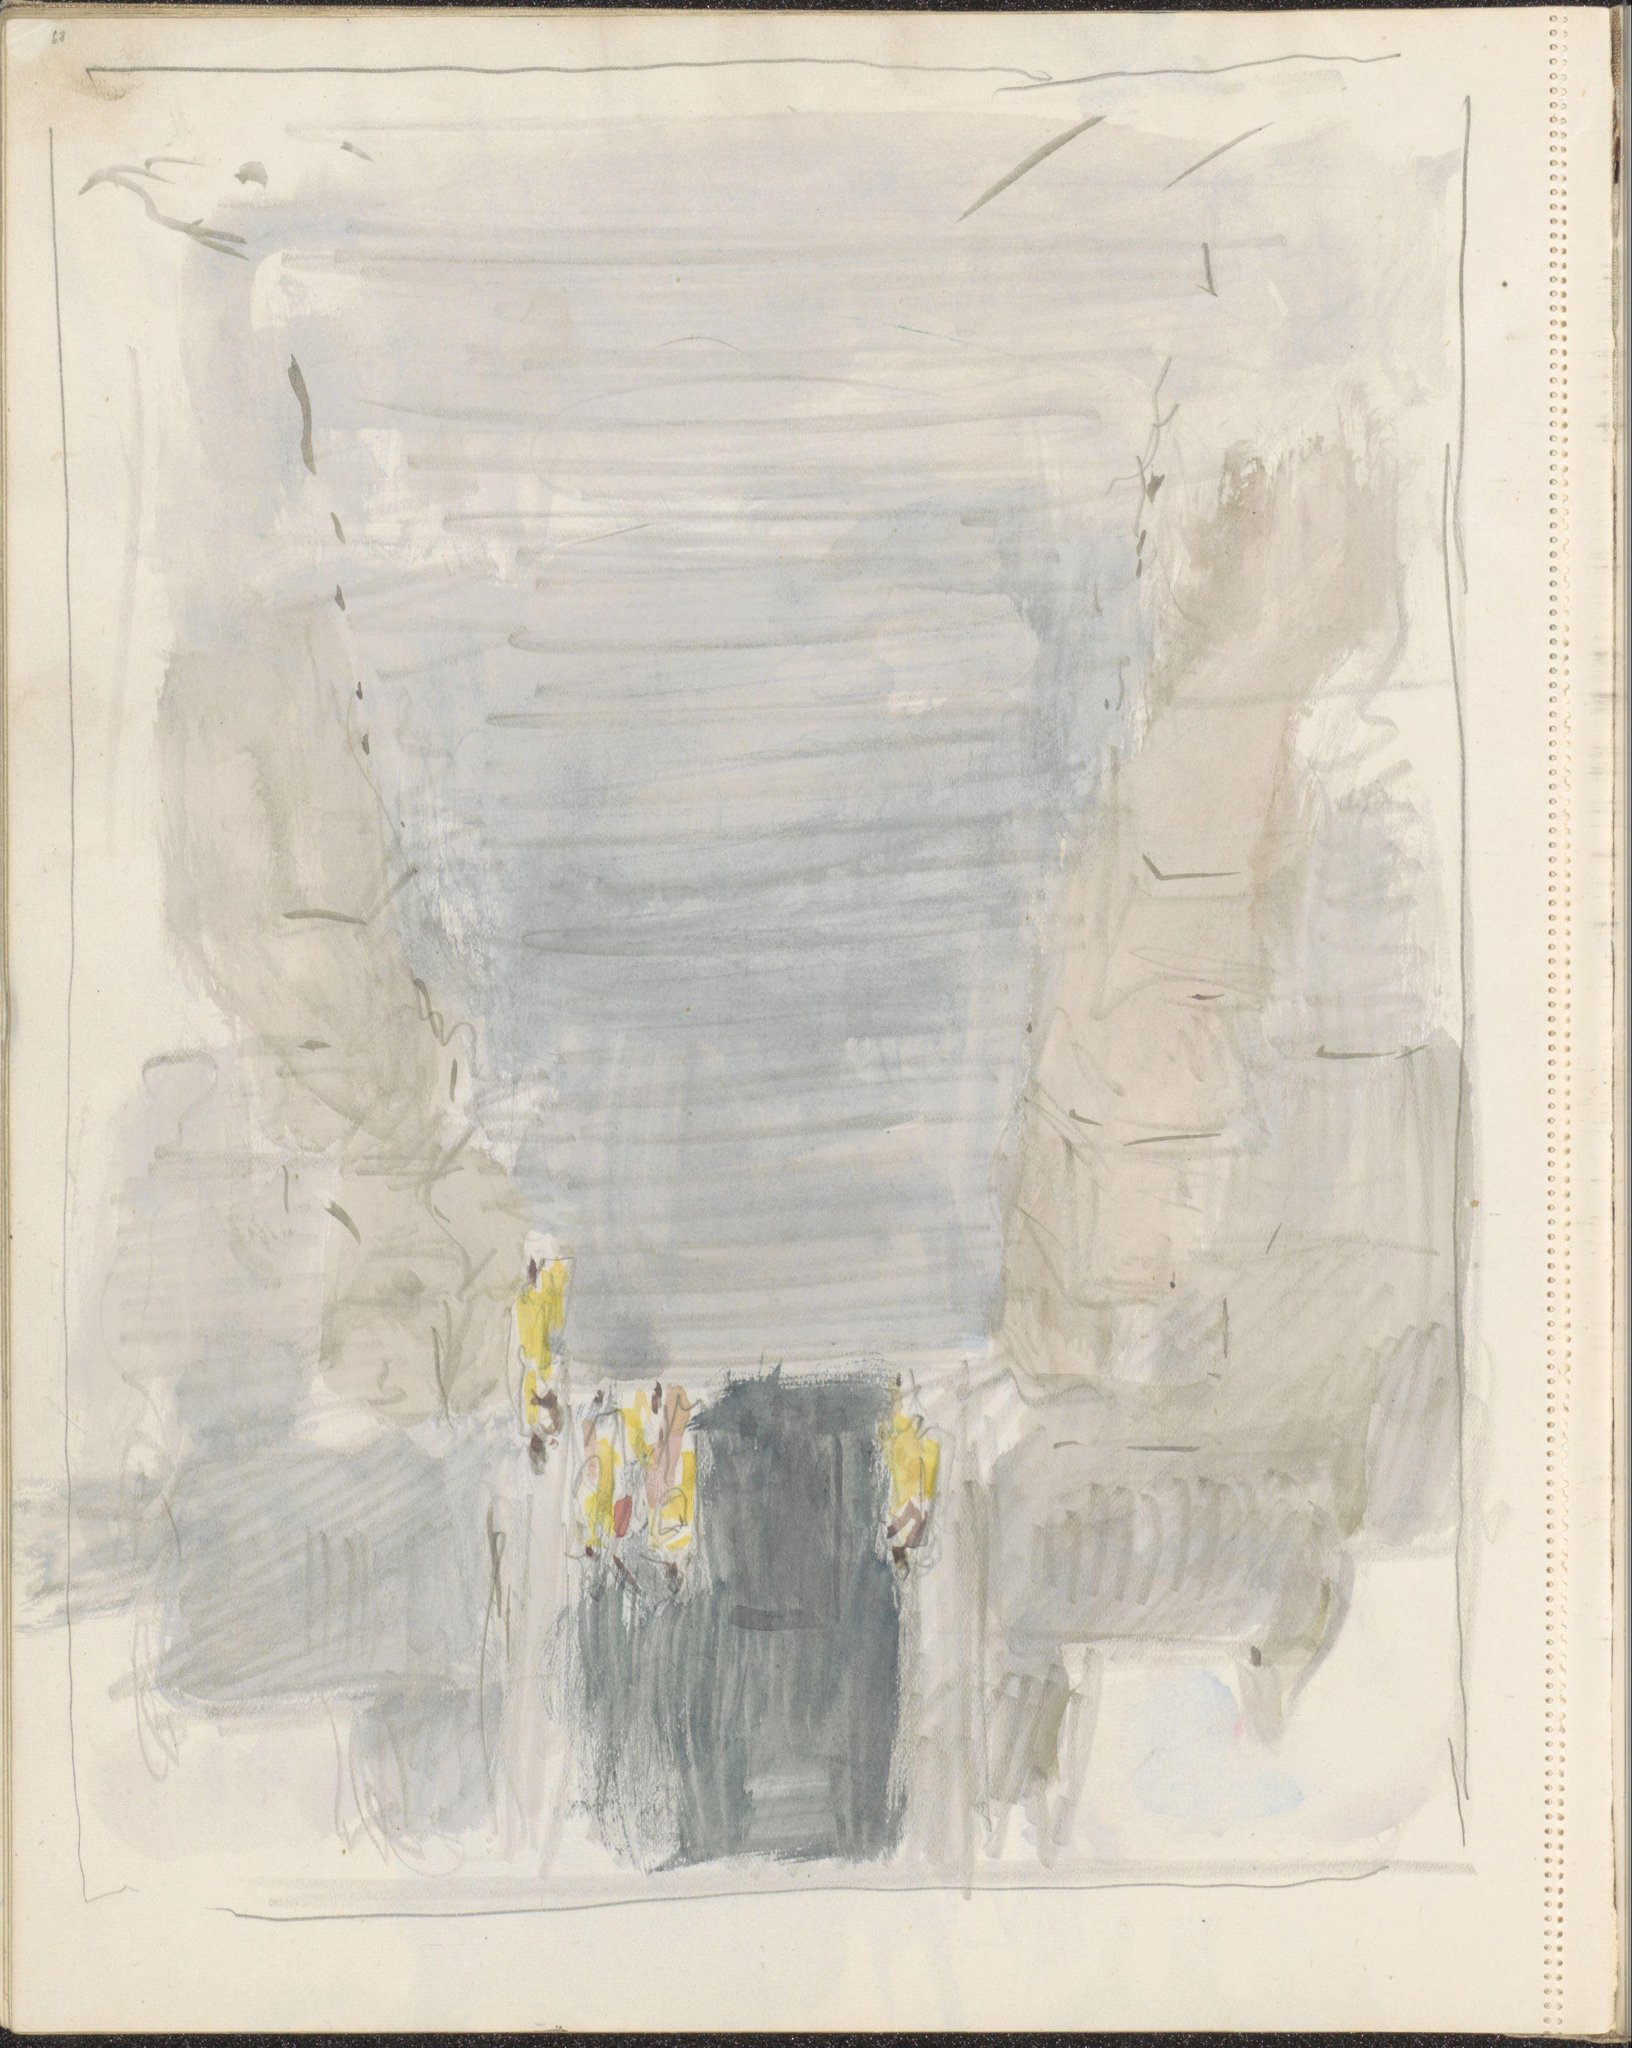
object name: sketchbook leaf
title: Boeddhistische monniken op de trap van de Angkor Wat tempel in Cambodja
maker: marius bauer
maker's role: draughtsman, print maker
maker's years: 1867-1932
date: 1931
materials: paper, pencil, watercolor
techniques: brush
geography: cambodia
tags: temple, shrine ~ hinduism, buddhism, jainism, flight of steps, religious functionaries ~ hinduism, buddhism, jainism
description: Pagina 68 uit een schetsboek met 48 bladen.